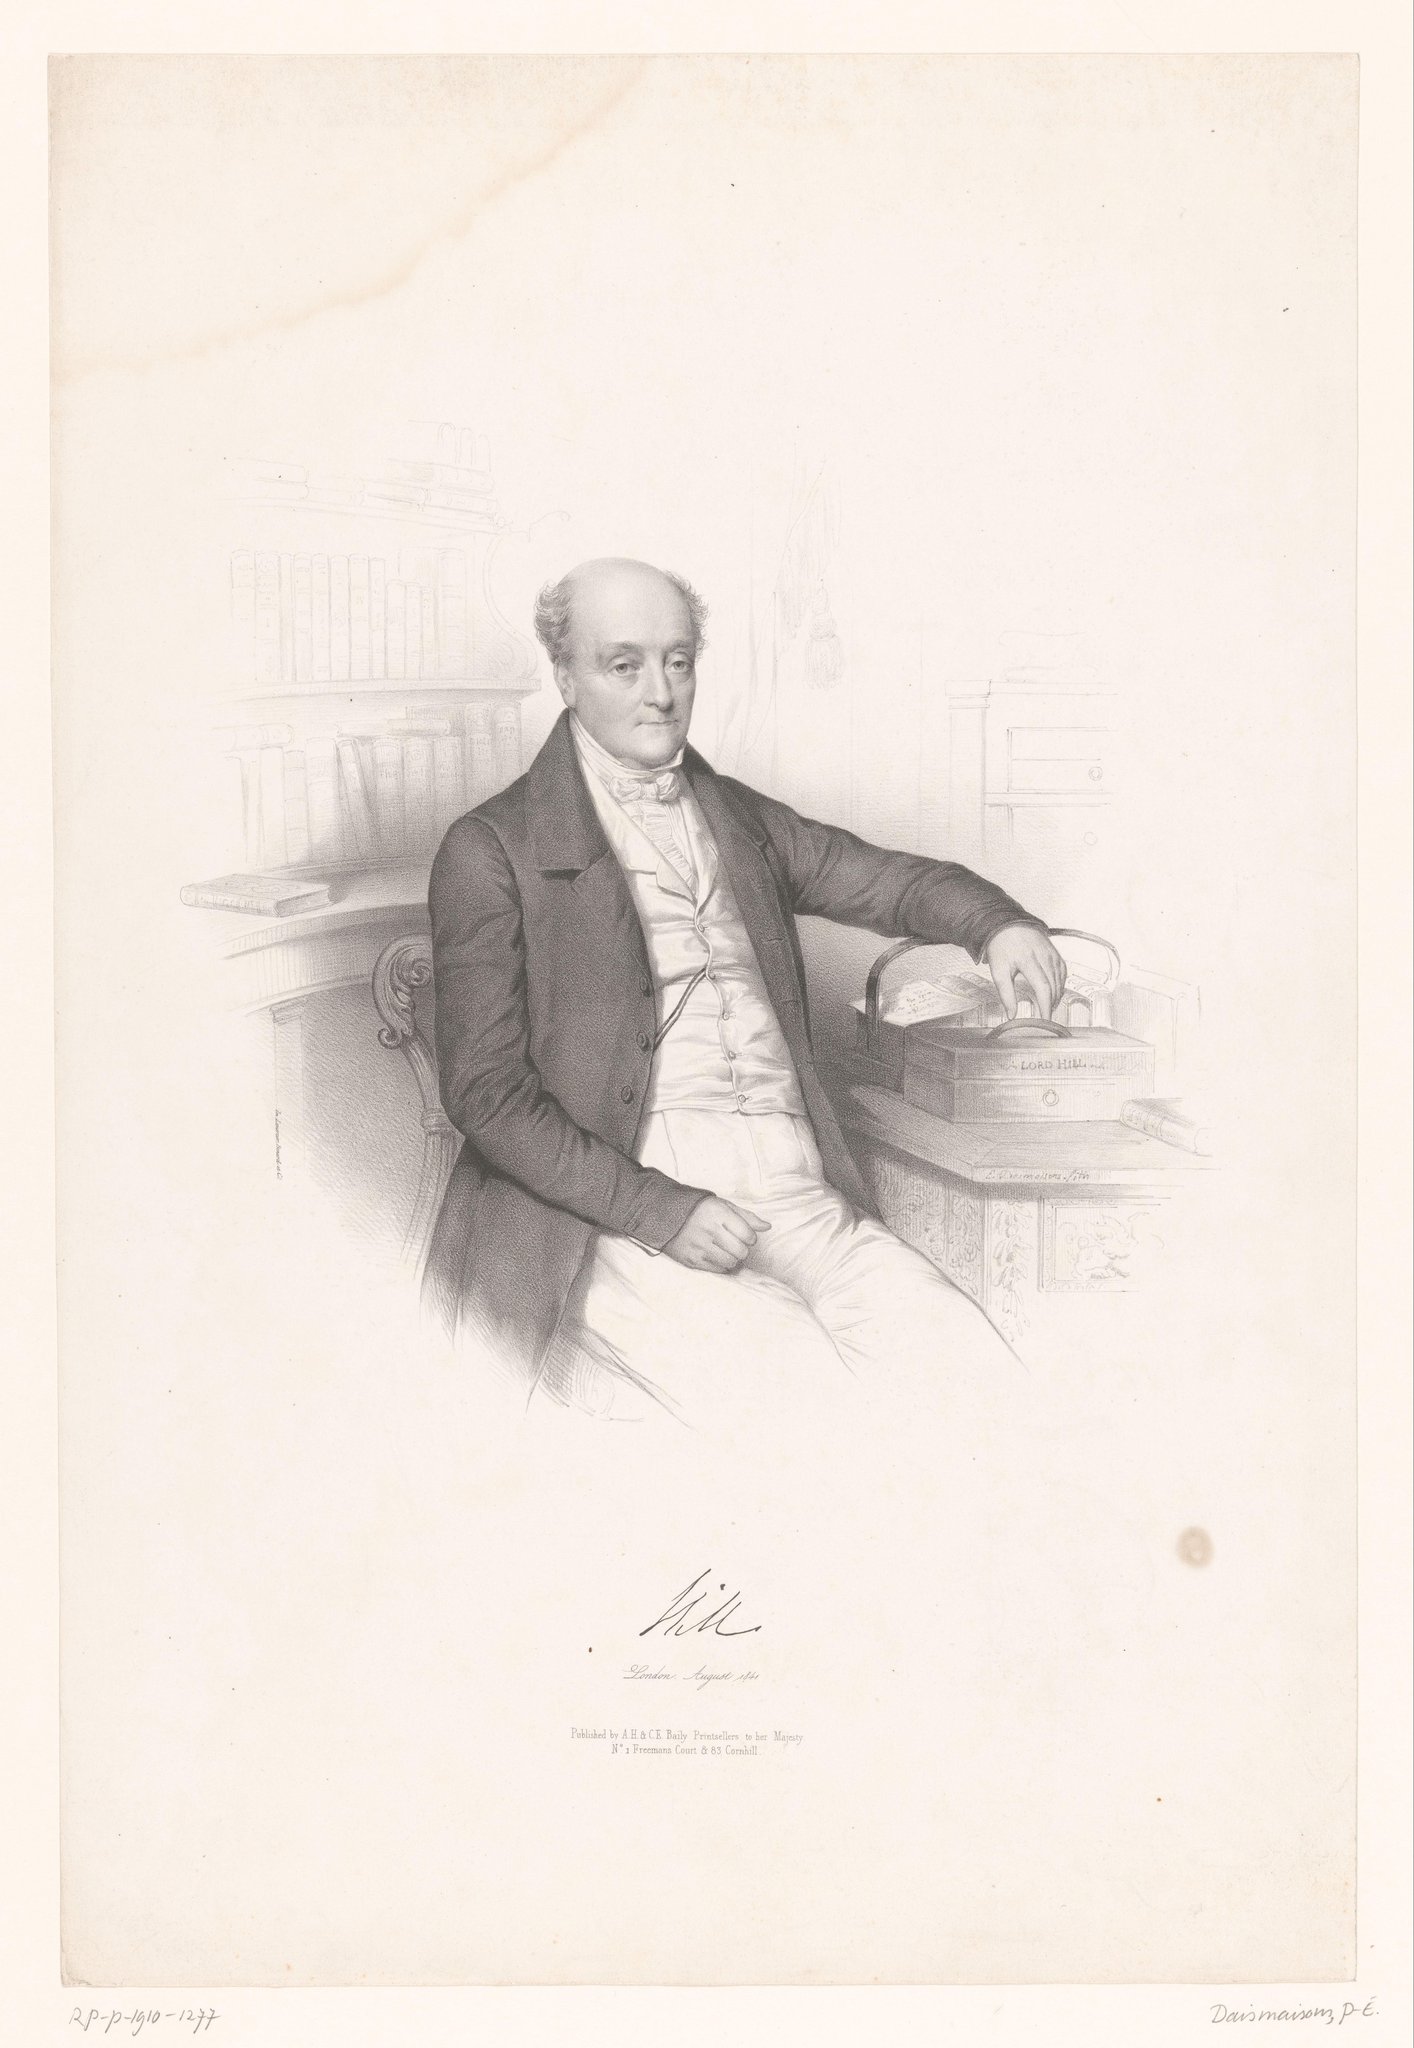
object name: print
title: Portret van generaal Rowland Hill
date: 1841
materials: paper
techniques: lithograph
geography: paris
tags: historical persons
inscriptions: collector's mark: Lugt 2228a